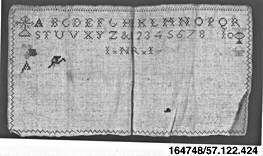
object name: sampler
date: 1801-1900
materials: cotton, linen, silk